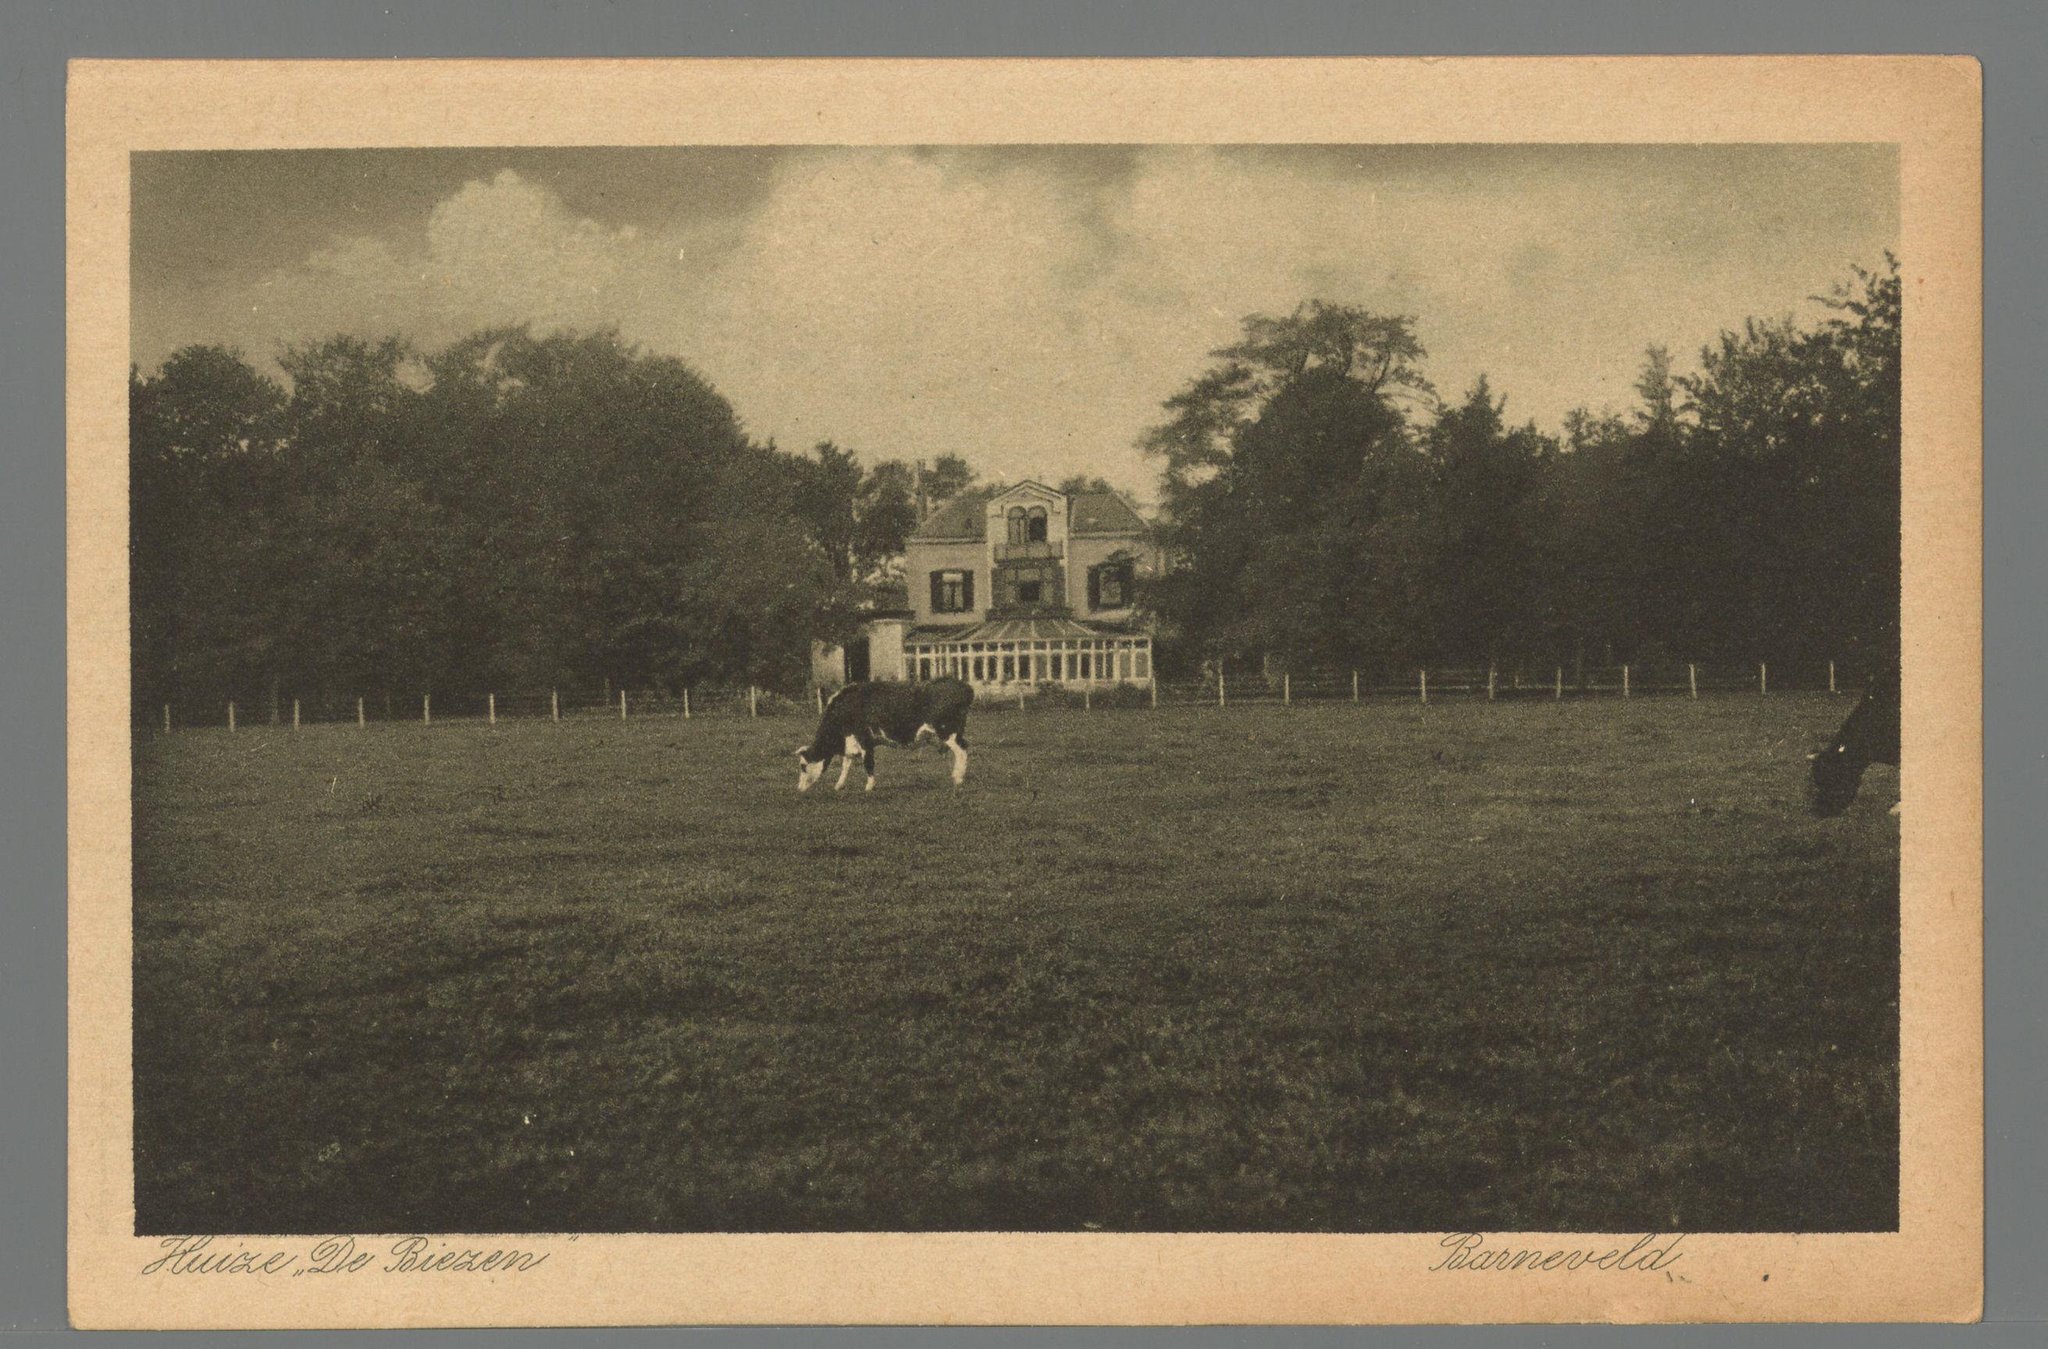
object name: ansichtkaart, prentbriefkaart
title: Huize "De Biezen". Barneveld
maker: Anonymous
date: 1913-1930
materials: cardboard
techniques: photograph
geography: barneveld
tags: cow, villa